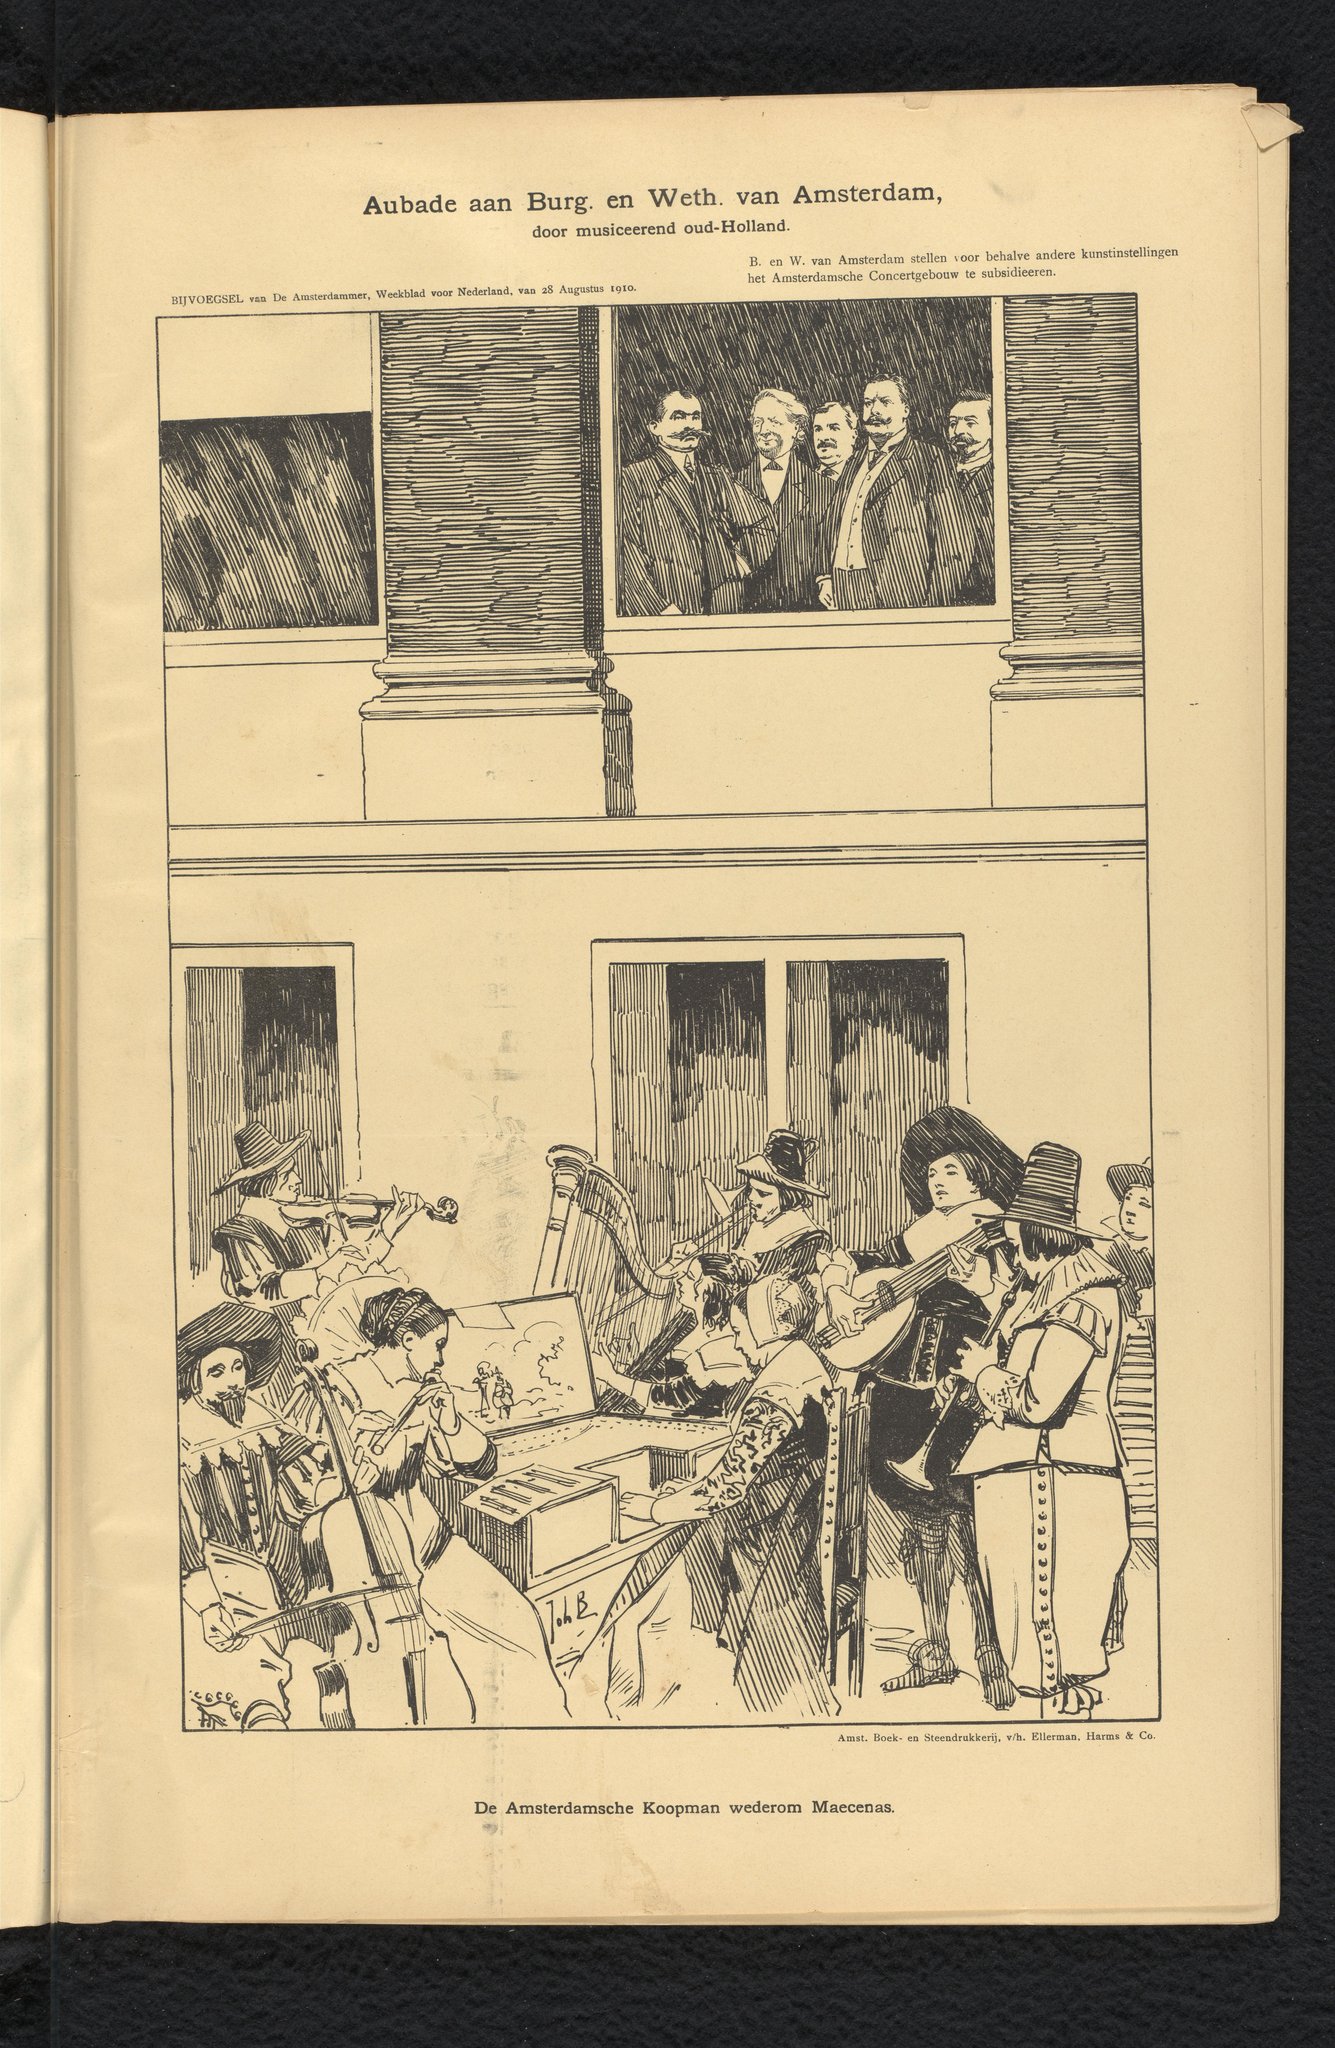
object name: cartoon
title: Aubade aan Burg. en Weth. van Amsterdam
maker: johan braakensiek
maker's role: draughtsman, print maker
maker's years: 1858-1940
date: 1910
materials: paper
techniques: lithograph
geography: netherlands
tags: small group of musicians, chamber orchestra, jazz band, municipal government, political caricatures and satires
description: Een orkest in zeventiende-eeuwse dracht brengt een muzikale aubade aan de burgemeester en wethouders van Amsterdam. Als dank voor gemeentelijke subsidie aan het Concertgebouw.